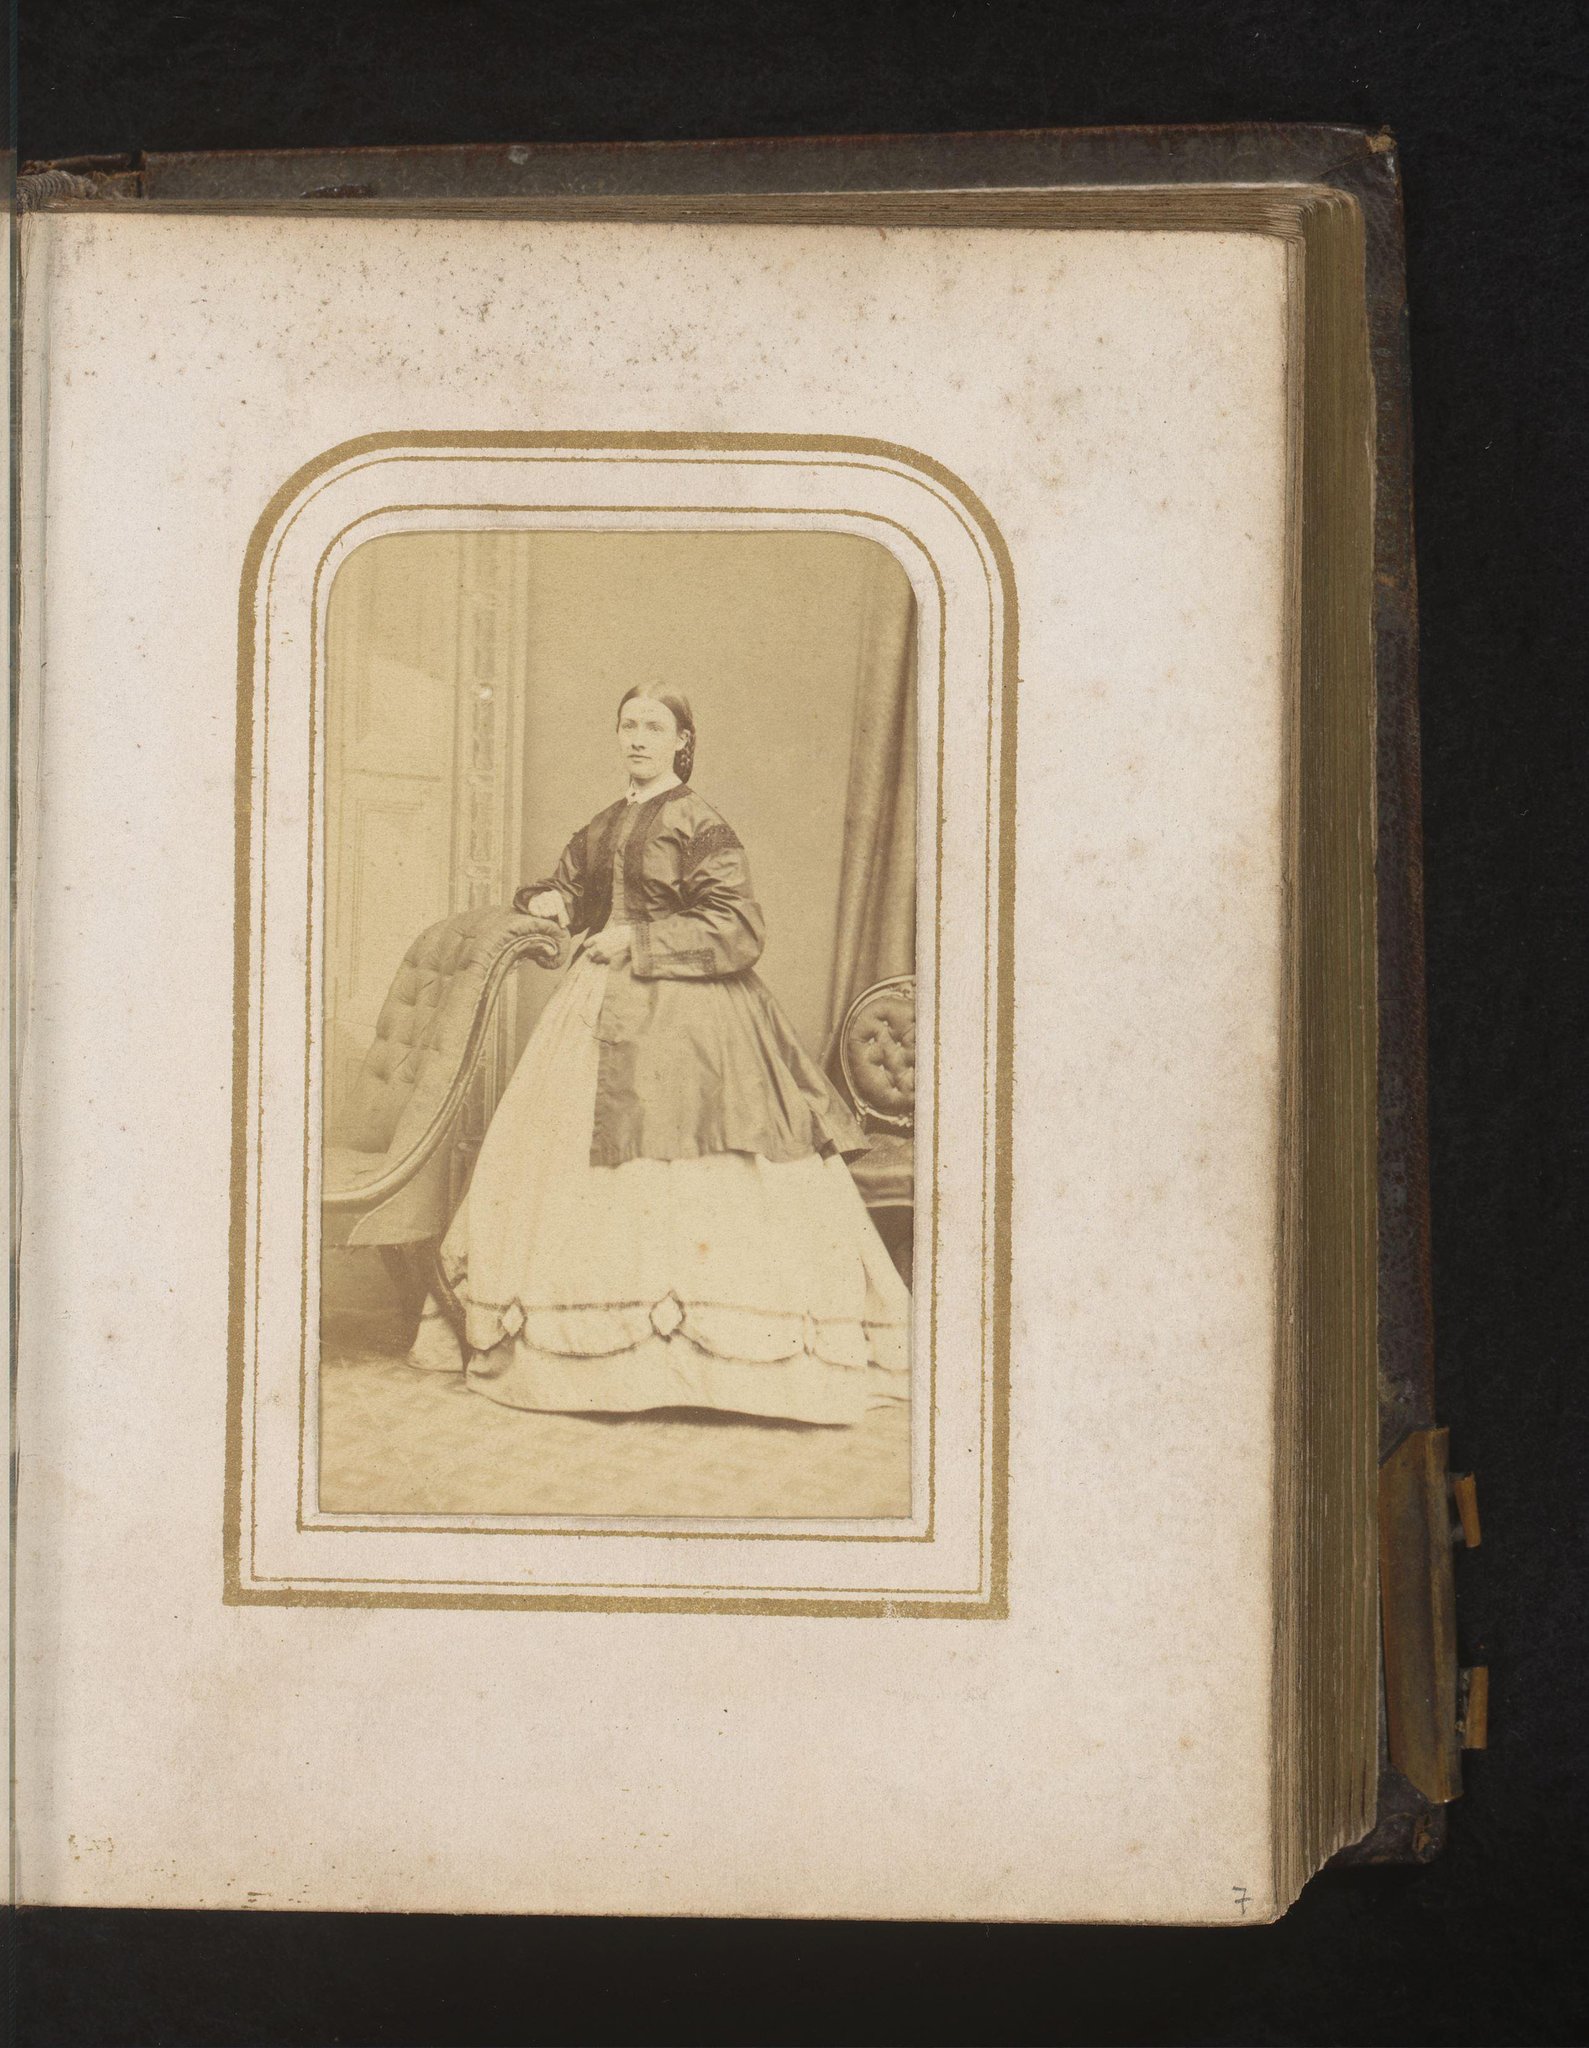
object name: photograph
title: Portret van een vrouw, staand bij een stoel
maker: john gibson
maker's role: fotograaf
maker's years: 1826-1920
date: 1860-1880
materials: cardboard, photographic support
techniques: albumen print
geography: belfast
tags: historical persons - bb - woman, standing figure - aa - female human figure, chair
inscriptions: inscription: ‘GIBSON'S/ Portrait Studio/ 20, Castle Lane/ BELFAST./ Plain & Coloured Portraits/ Singly or in Groups/ VISITE PORTRAITS/ 6 copies 8. 12 copies 12’